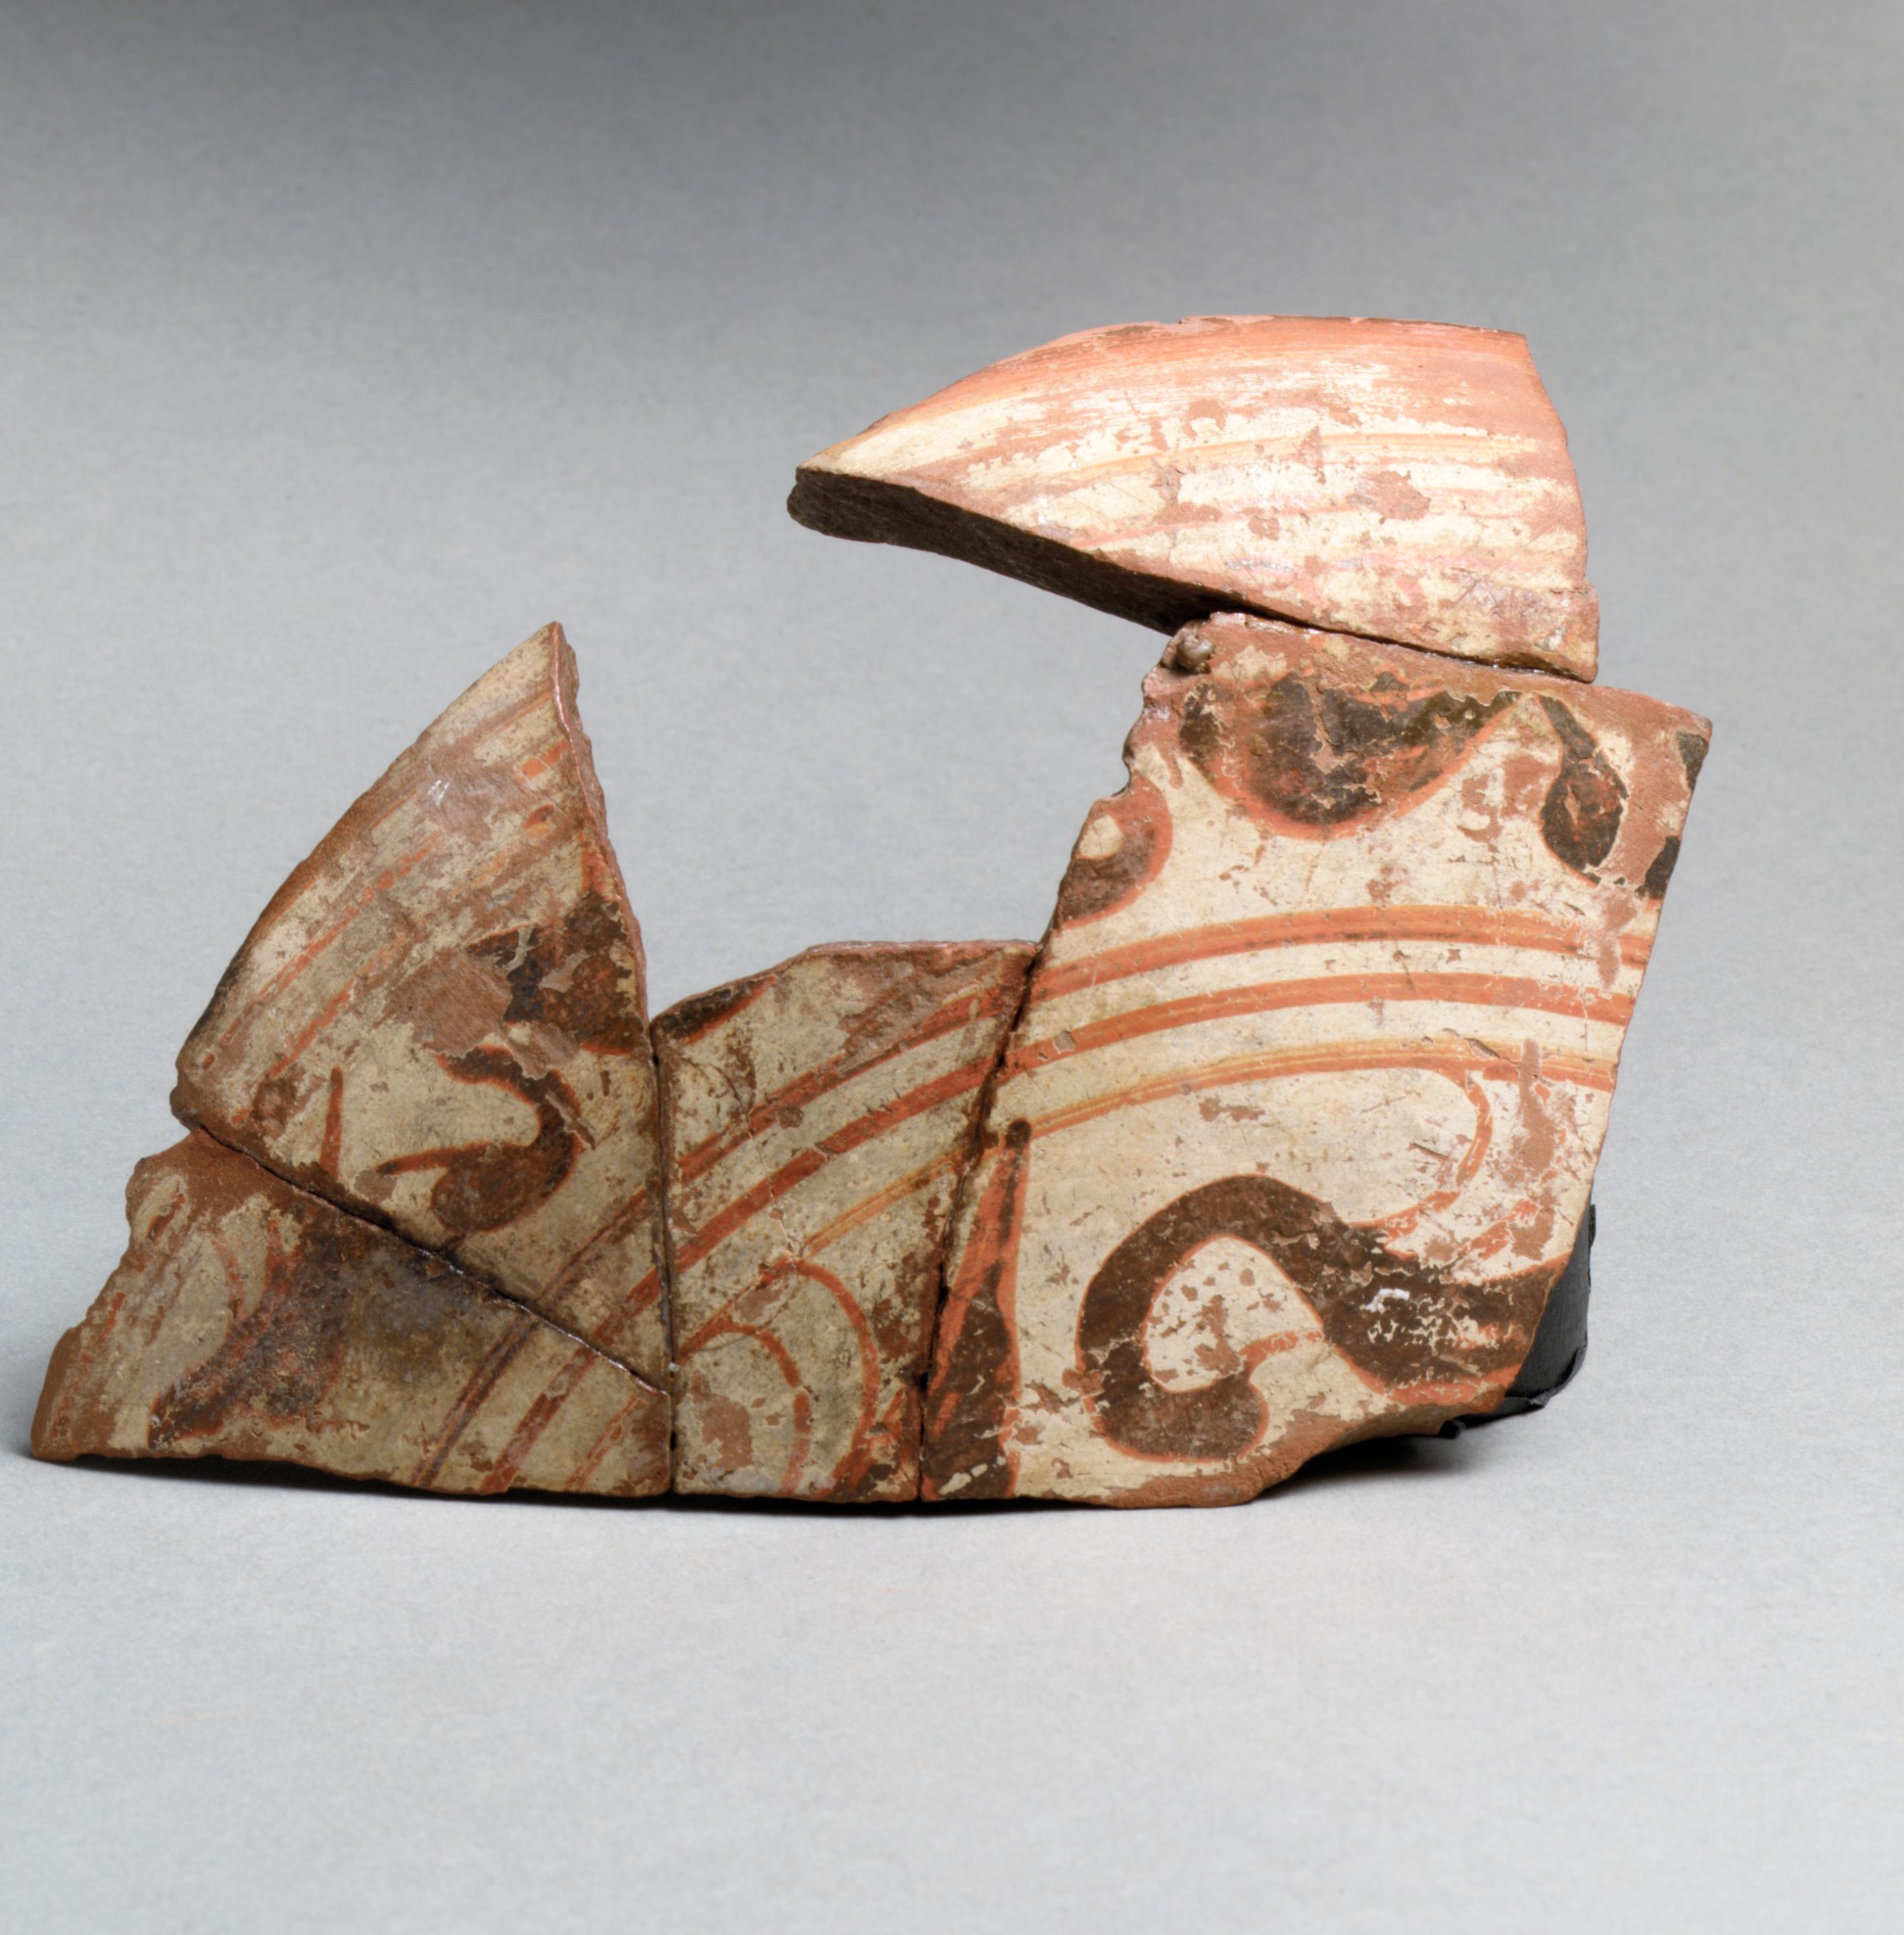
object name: vase fragment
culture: greek or lydian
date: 900-30 BCE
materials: terracotta